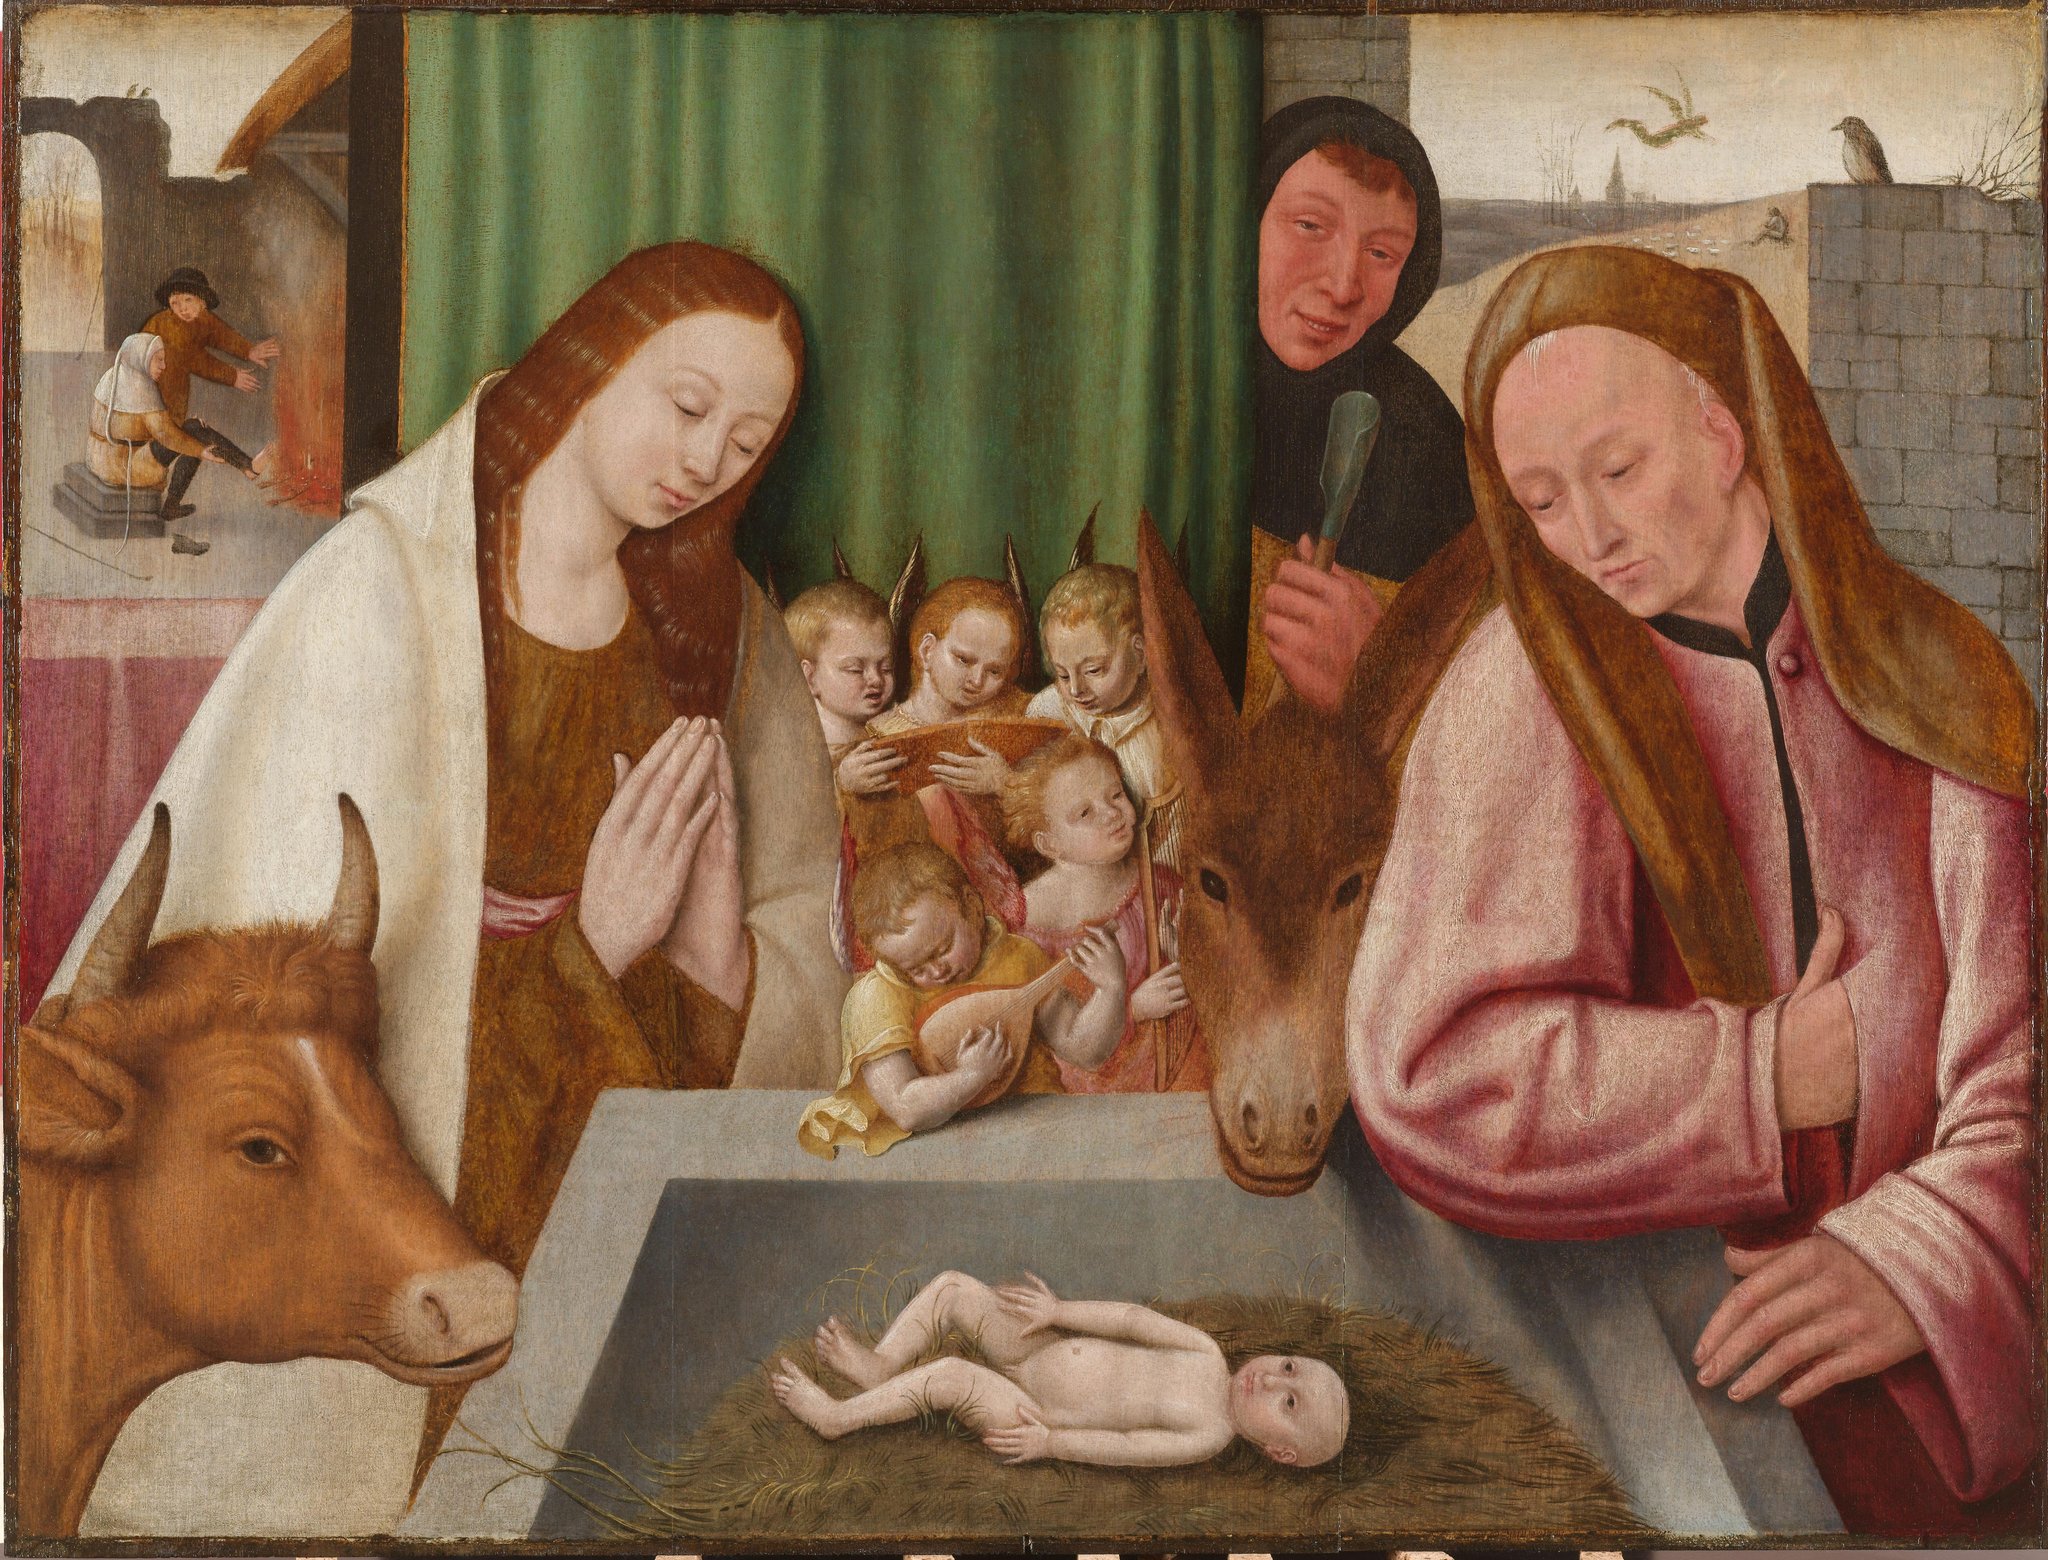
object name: painting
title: Nativity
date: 1550-1600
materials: oil, panel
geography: southern netherlands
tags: adoration of the christ-child by mary and joseph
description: De aanbidding van het Christuskind. Maria en Jozef aan weerszijden van een stenen bak waarin het kind ligt. Hierbij de os en de ezel en een groepje musicerende en zingende engelen. Vanachter een gordijn kijkt een herder met staf toe. Links op de achtergrond twee mannen die zich warmen bij een vuur. Rechts in de verte de verkondiging aan de herders.